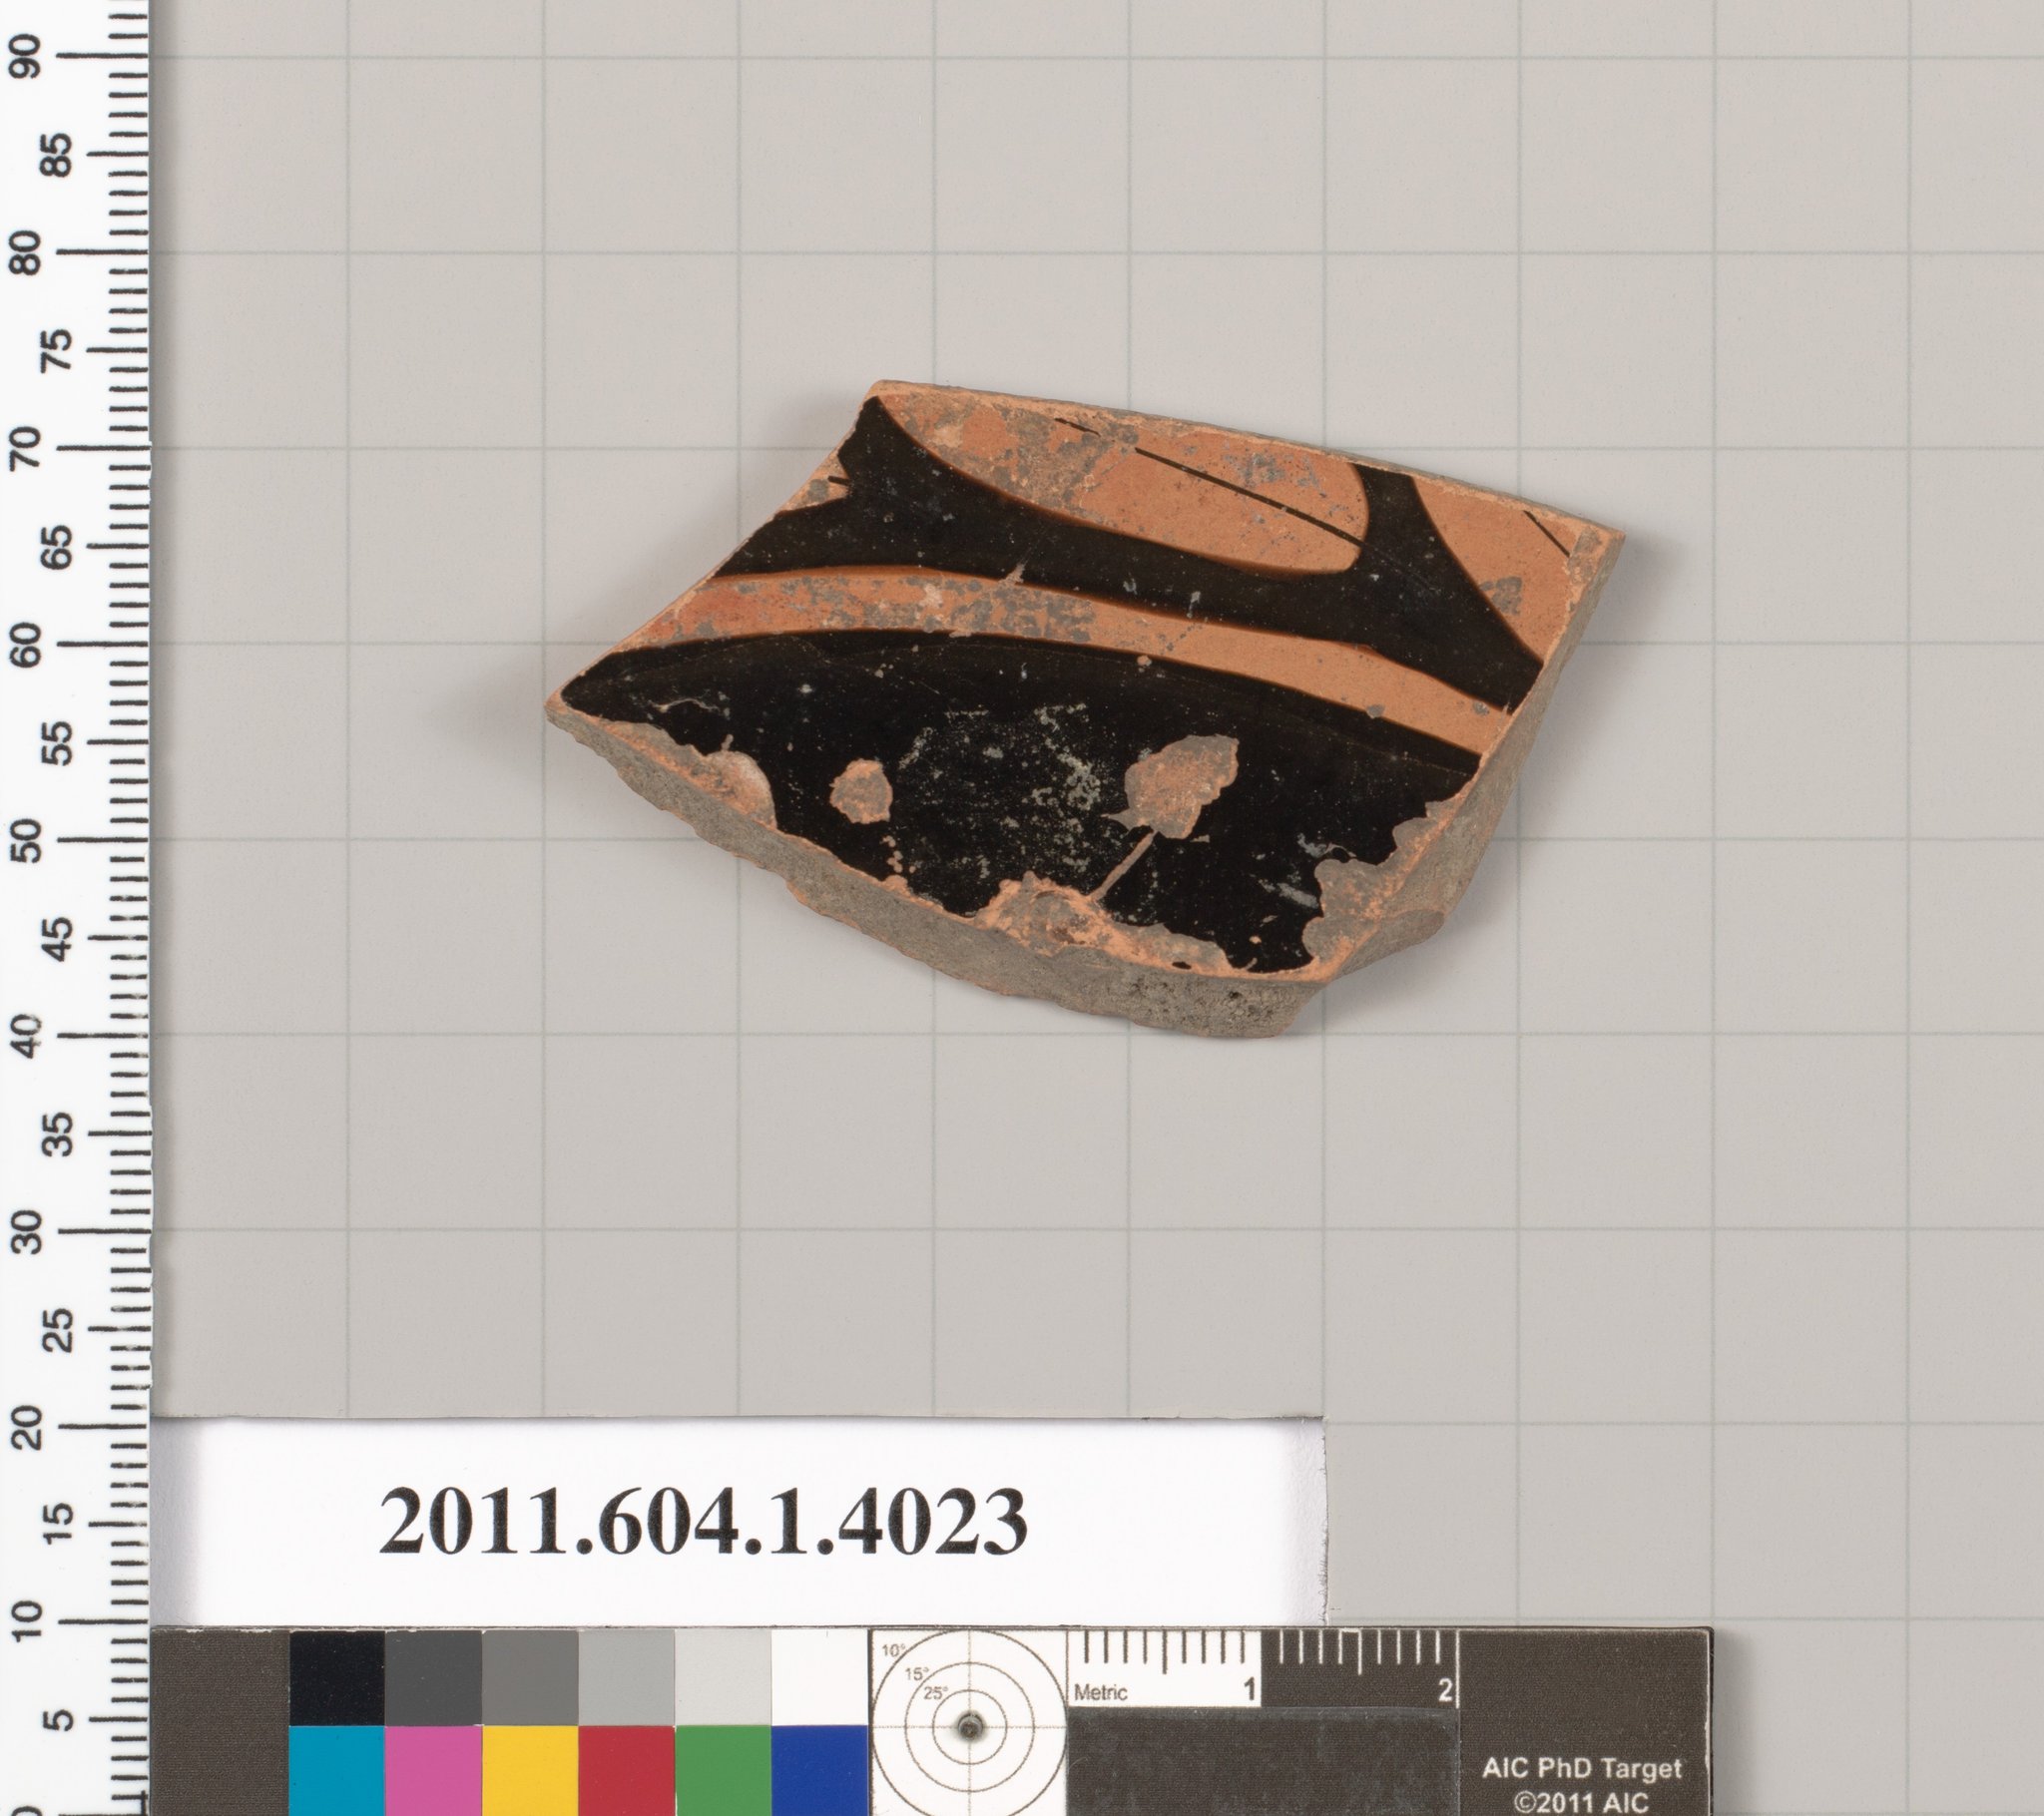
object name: kylix fragment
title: Terracotta fragment of a kylix (drinking cup)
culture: greek, attic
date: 460-440 BCE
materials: terracotta